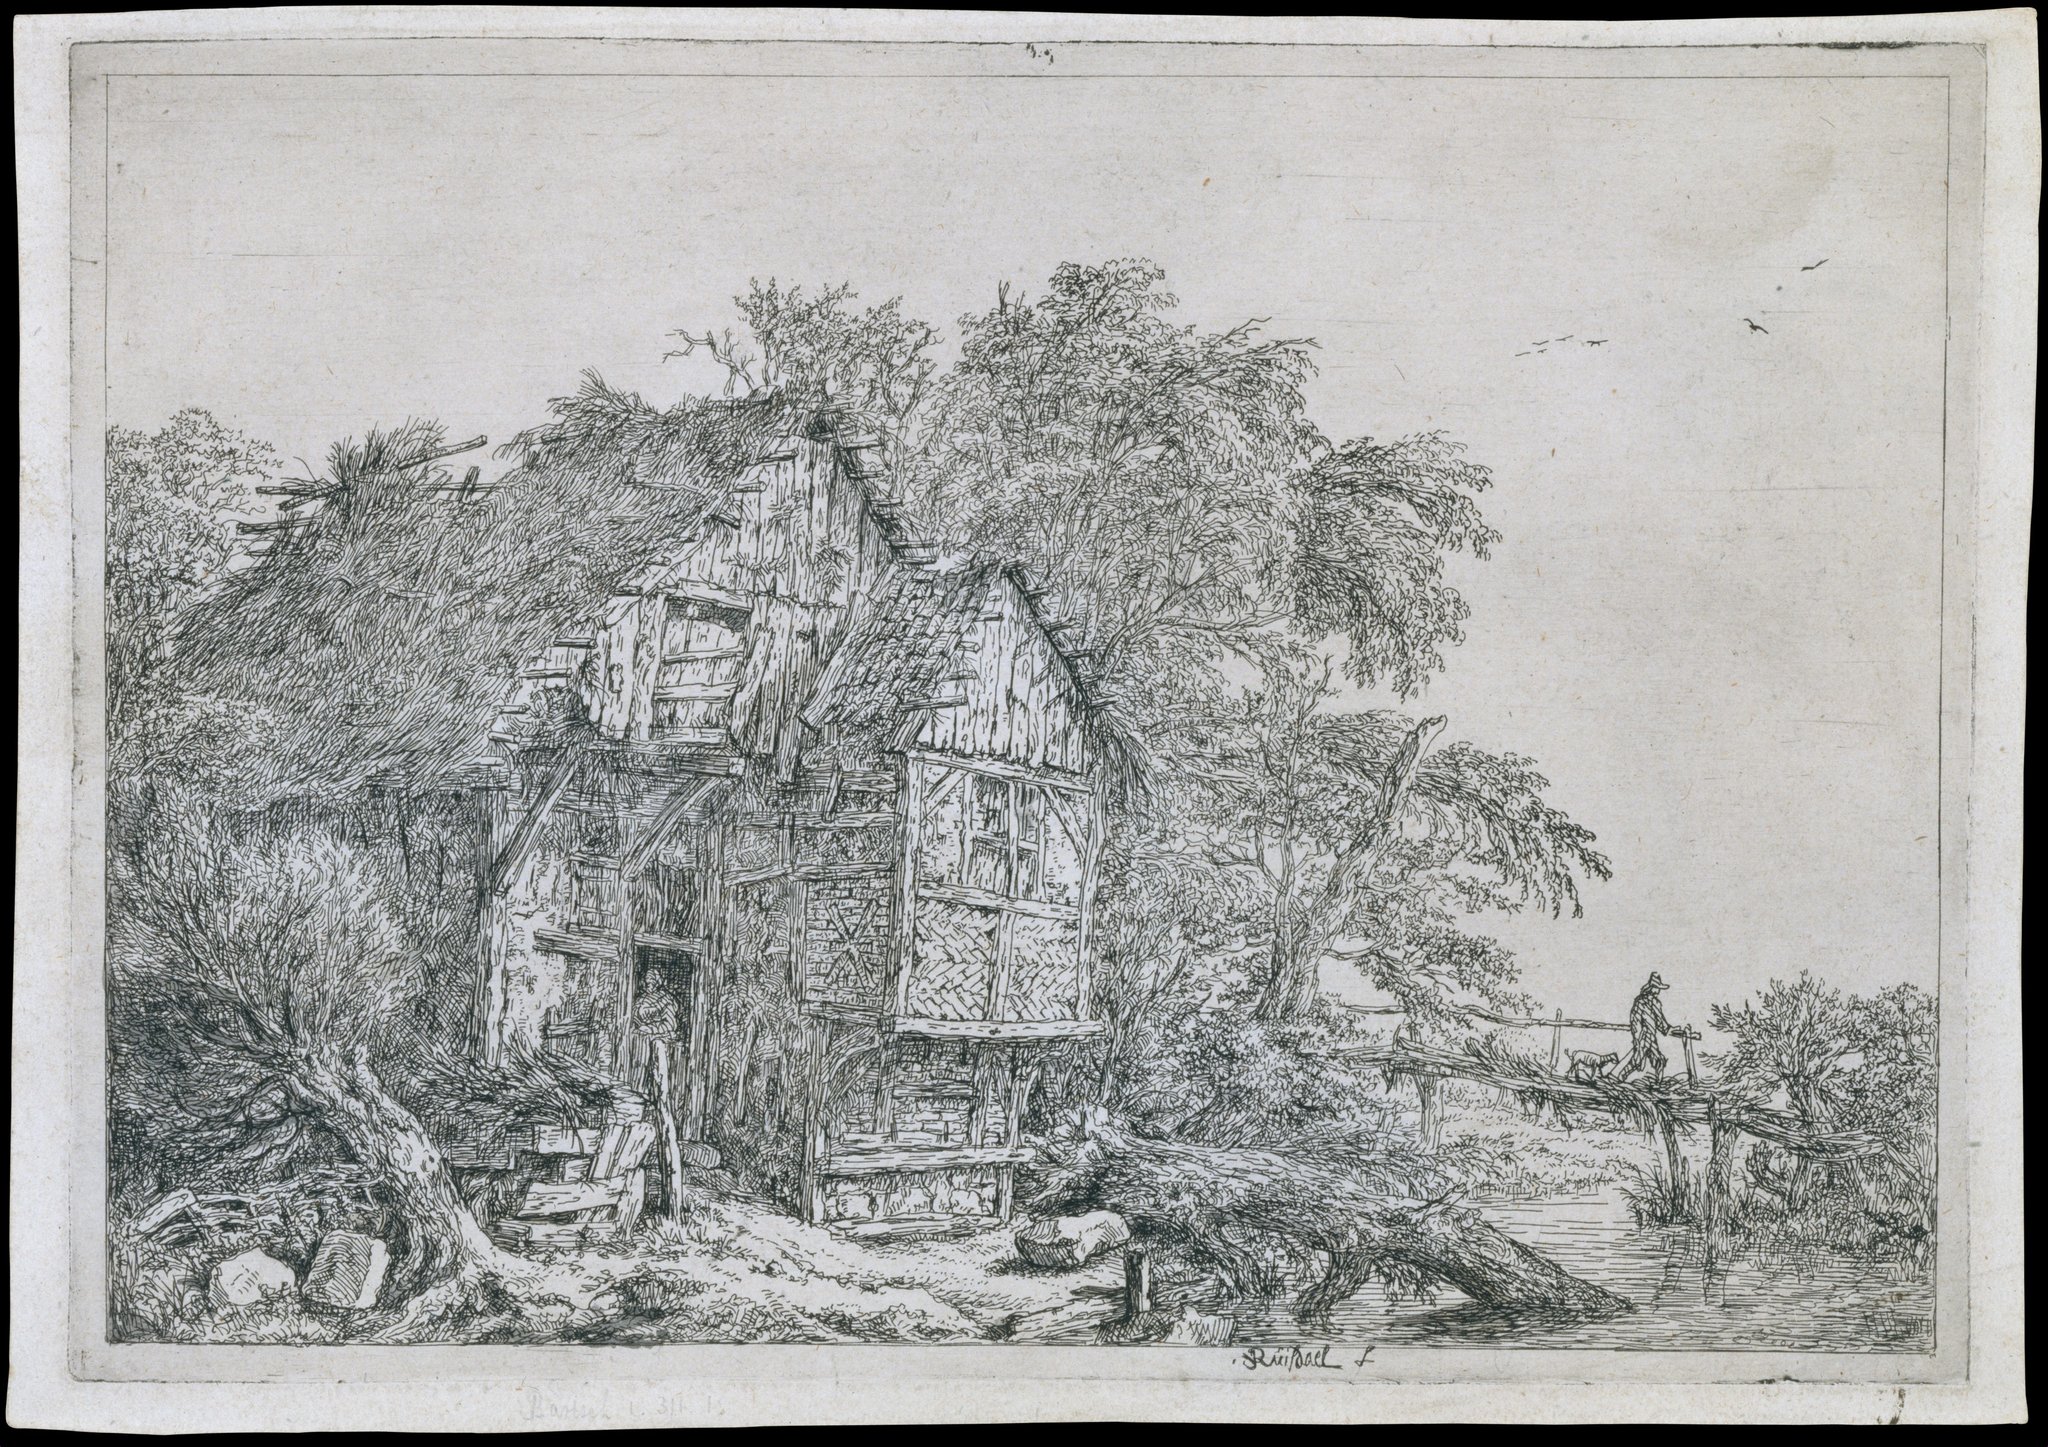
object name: print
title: The Little Bridge (Le Petit Pont)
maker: jacob isaacksz van ruisdael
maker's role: artist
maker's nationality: dutch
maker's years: 1628-1682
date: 1601-1700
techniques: etching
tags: houses,bridges,trees